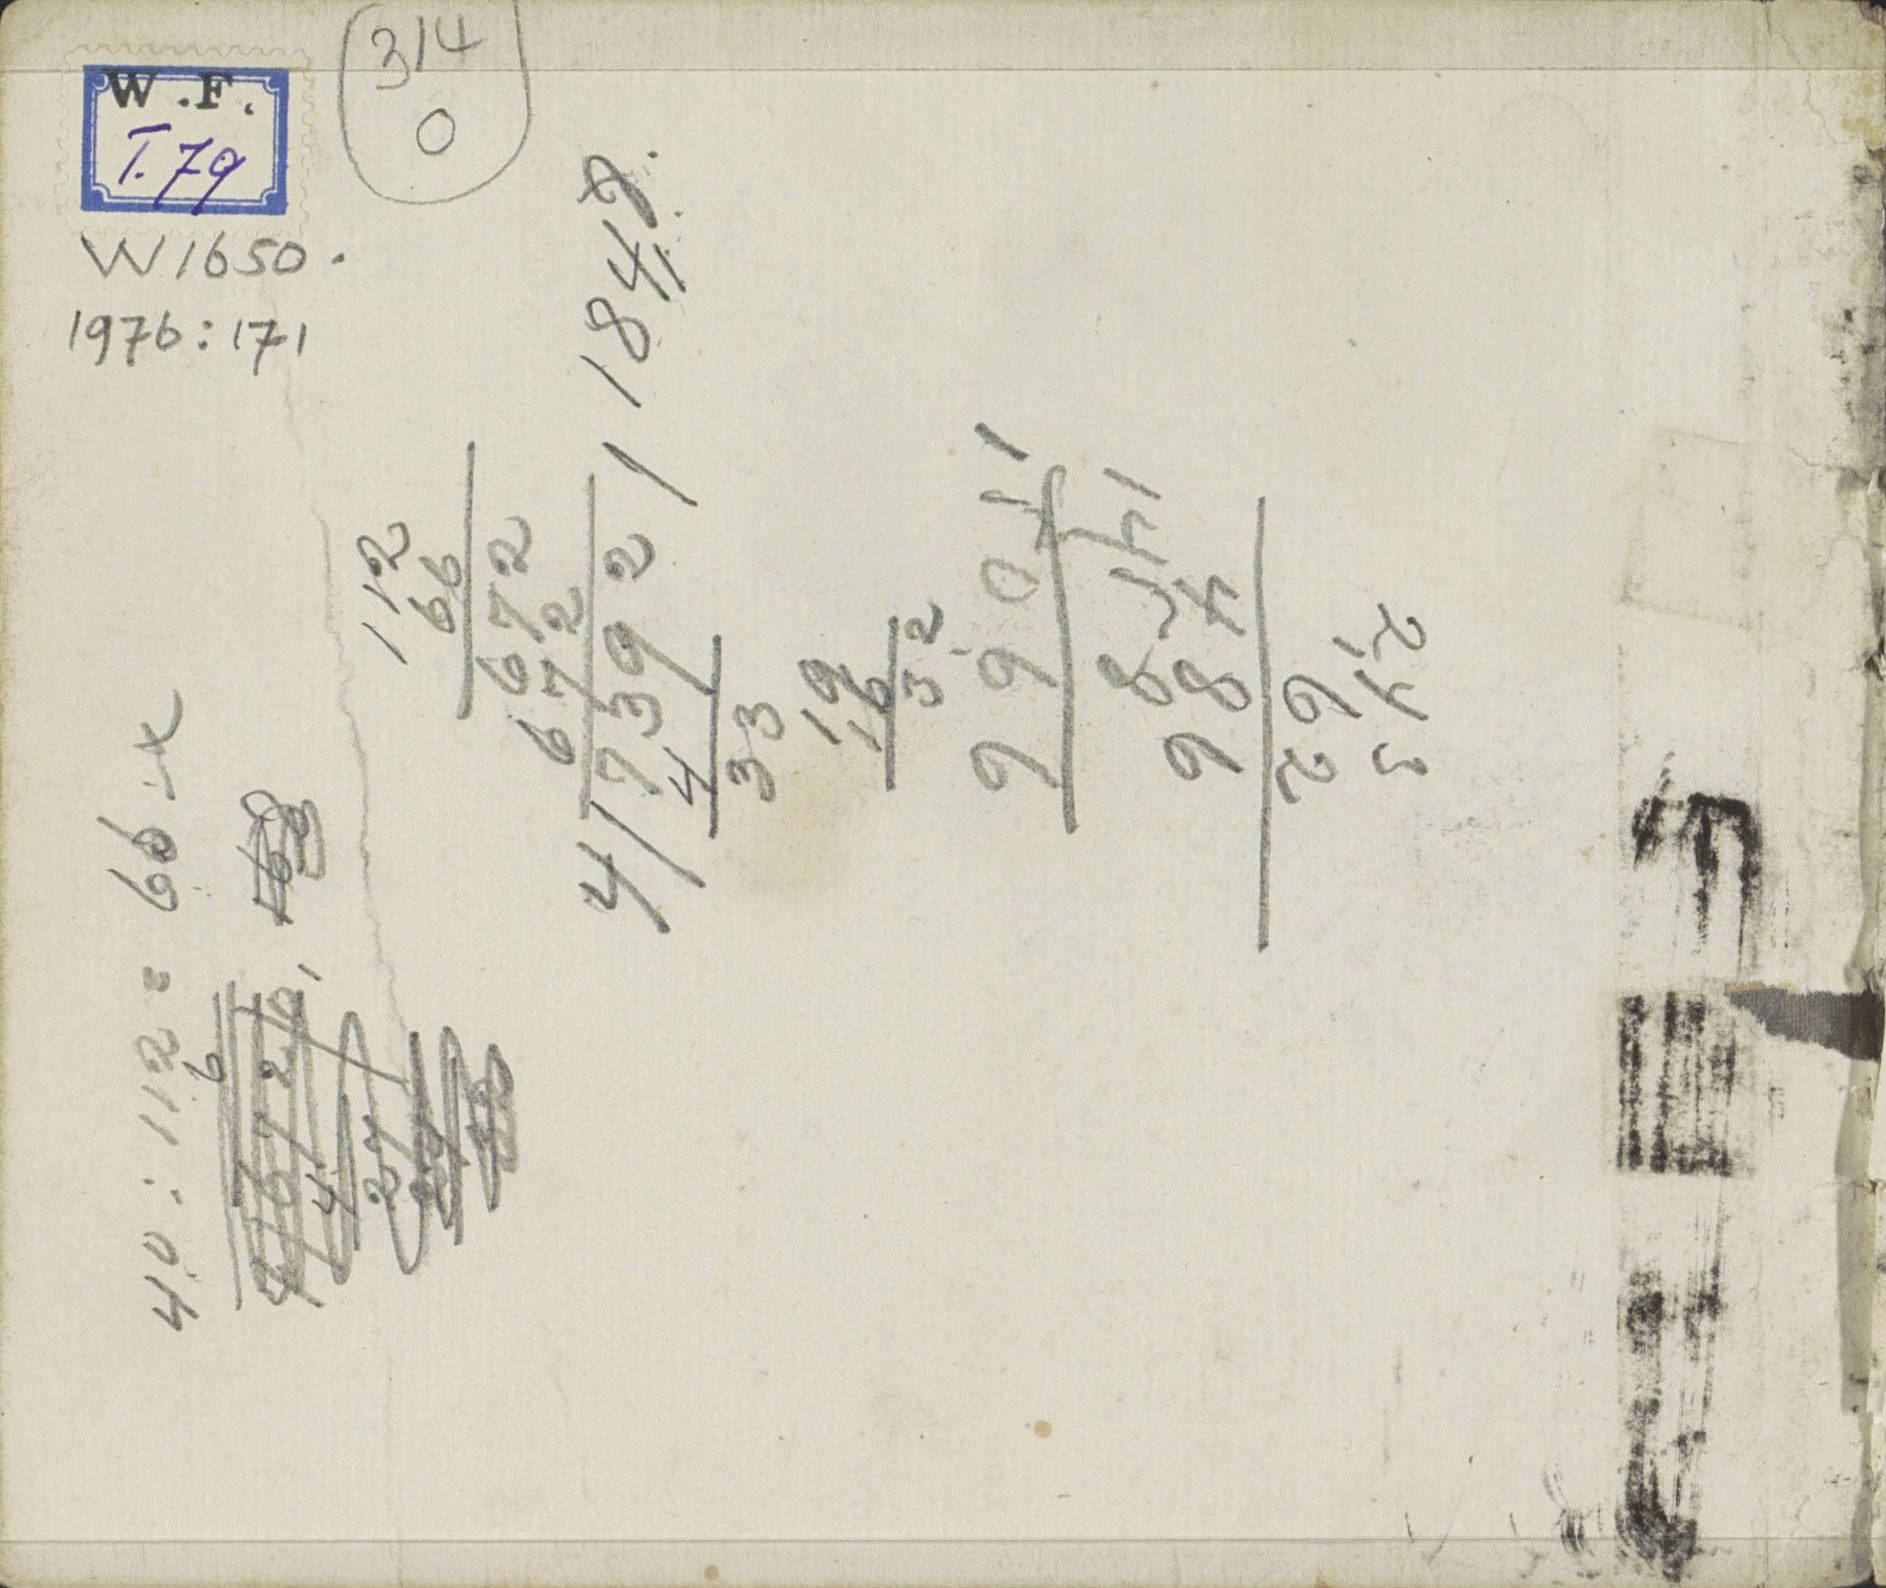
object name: endleaf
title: Annotaties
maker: willem witsen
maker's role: draughtsman, painter, print maker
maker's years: 1860-1923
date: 1915-1920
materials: paper, pencil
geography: amsterdam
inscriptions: annotation: ‘W.F./ T. 79’, annotation: ‘[...]’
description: Schutblad A, voorste schutblad, uit een schetsboek met 12 bladen.